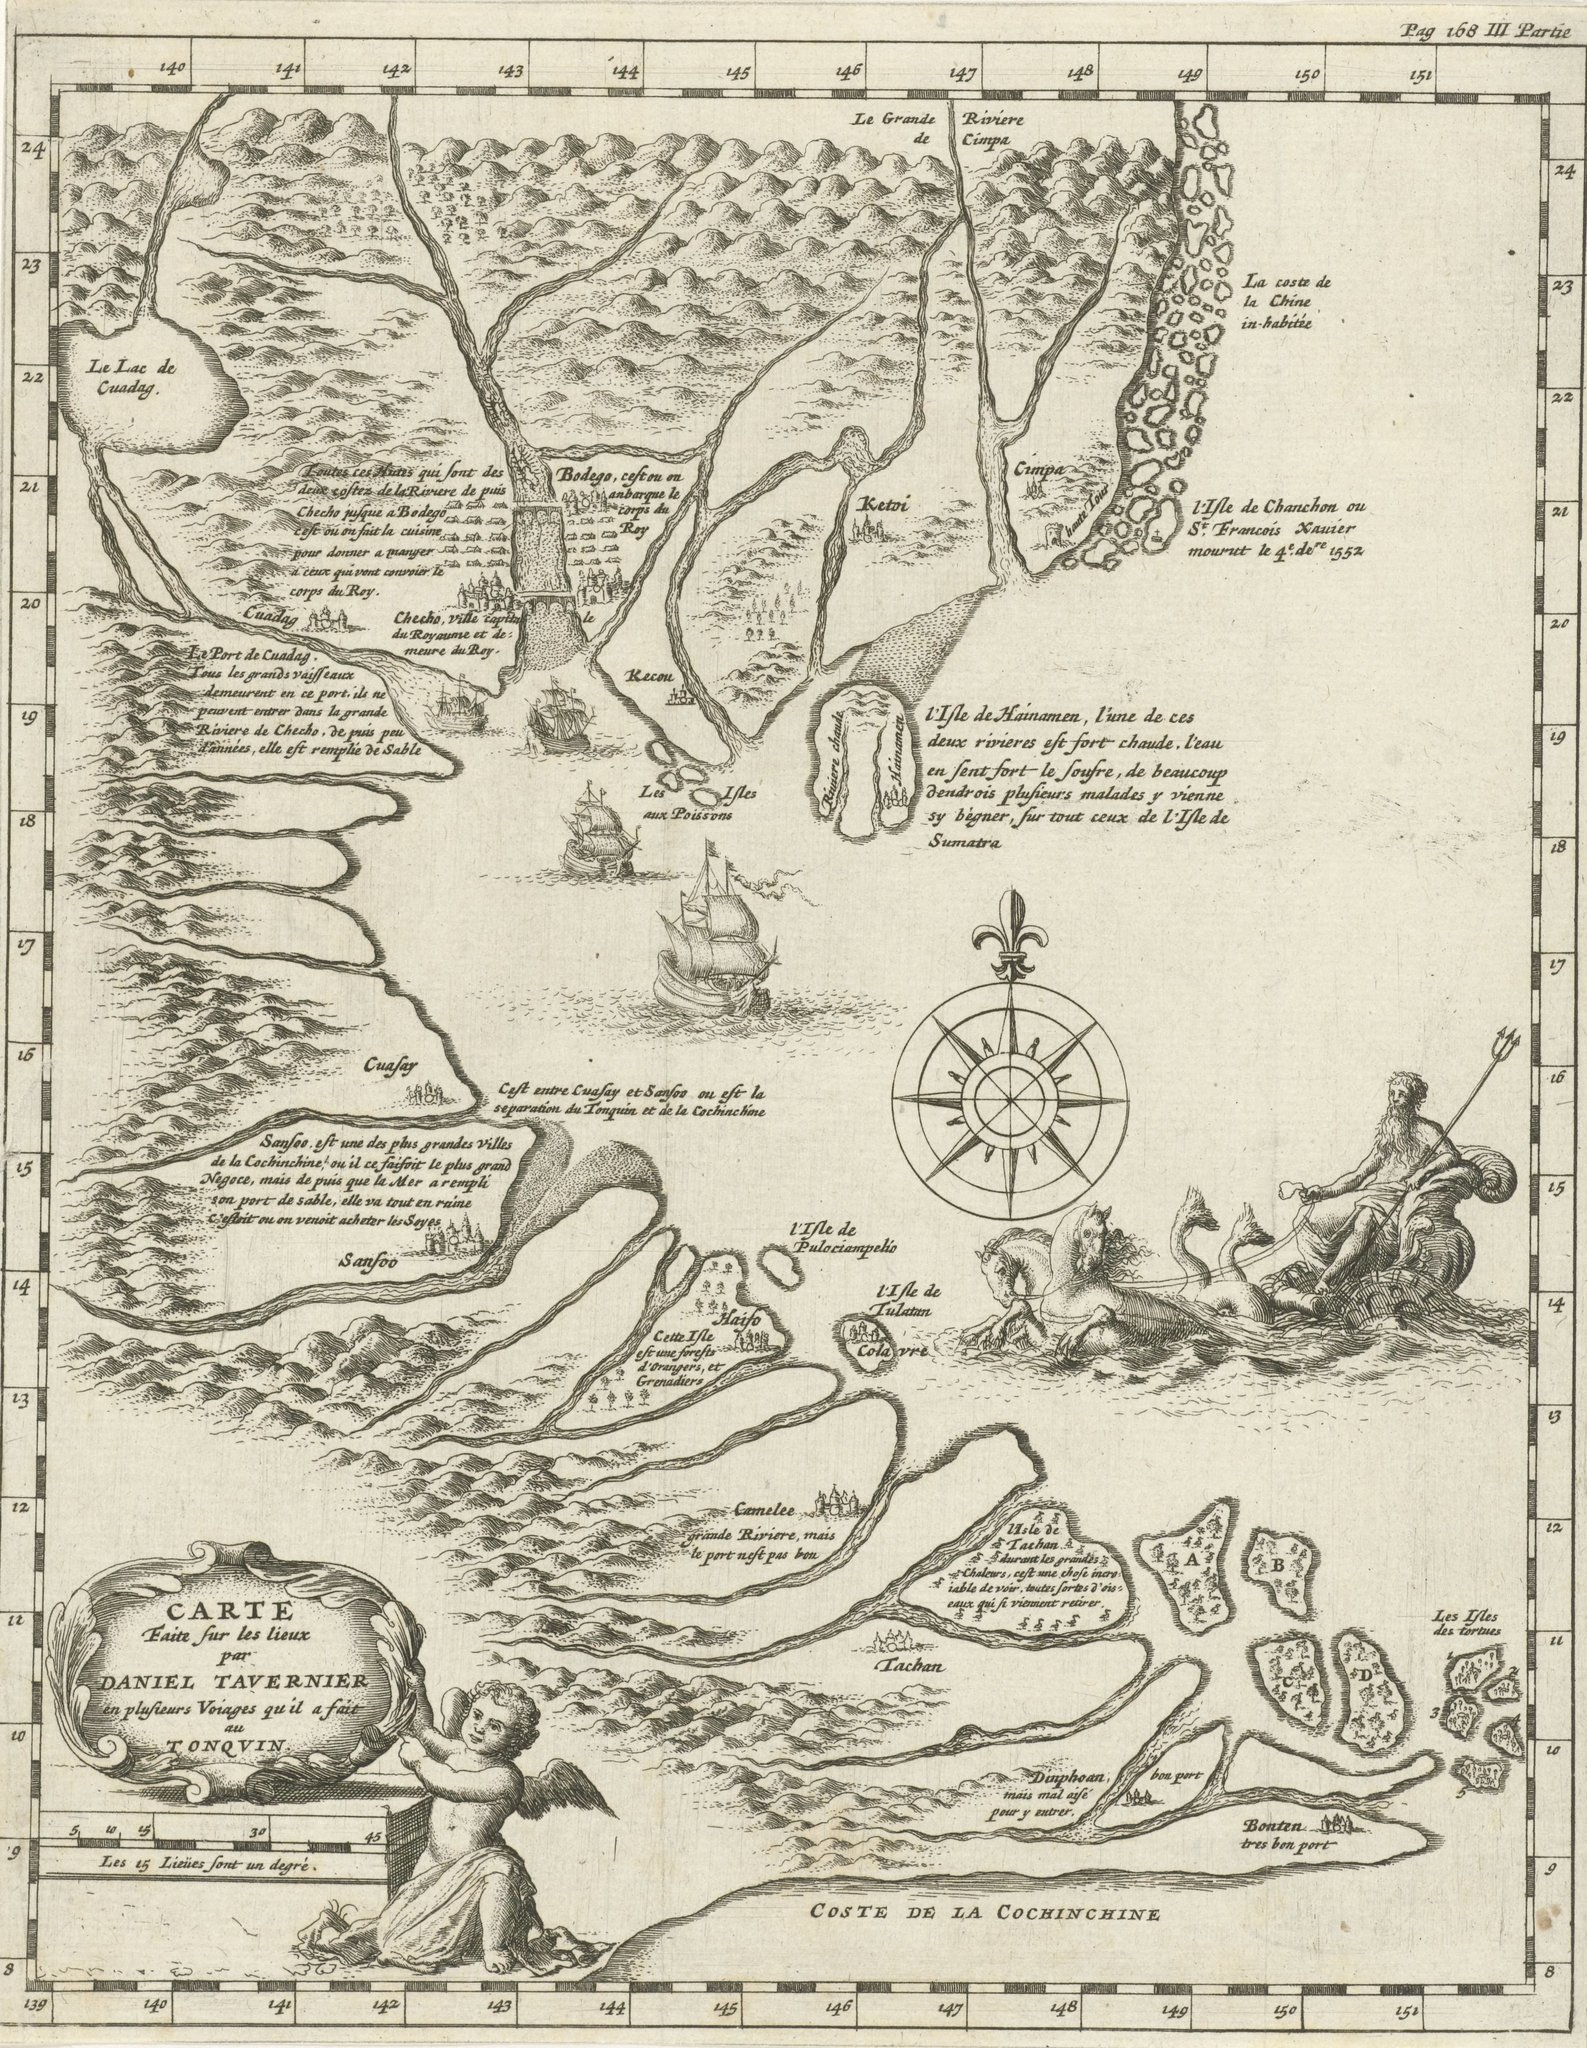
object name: print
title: Landkaart van Tonquin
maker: jan luyken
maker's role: draughtsman, print maker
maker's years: 1649-1712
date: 1681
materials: paper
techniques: etching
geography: amsterdam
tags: (story of) neptune (poseidon), maps of separate countries or regions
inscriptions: collector's mark: Lugt 2228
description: Illustratie vervaardigd voor deel III van: Tavernier, Jean Baptiste. Les six voyages de Jean Bapt. Tavernier (...) en Turquie, en Perse et aux Indes. Brussel: Eugène Henry Fricx, 1679. Tweede uitgave te Parijs, 1679-1681. Deel I en II verschenen in 1679. Deel III verscheen in 1681.